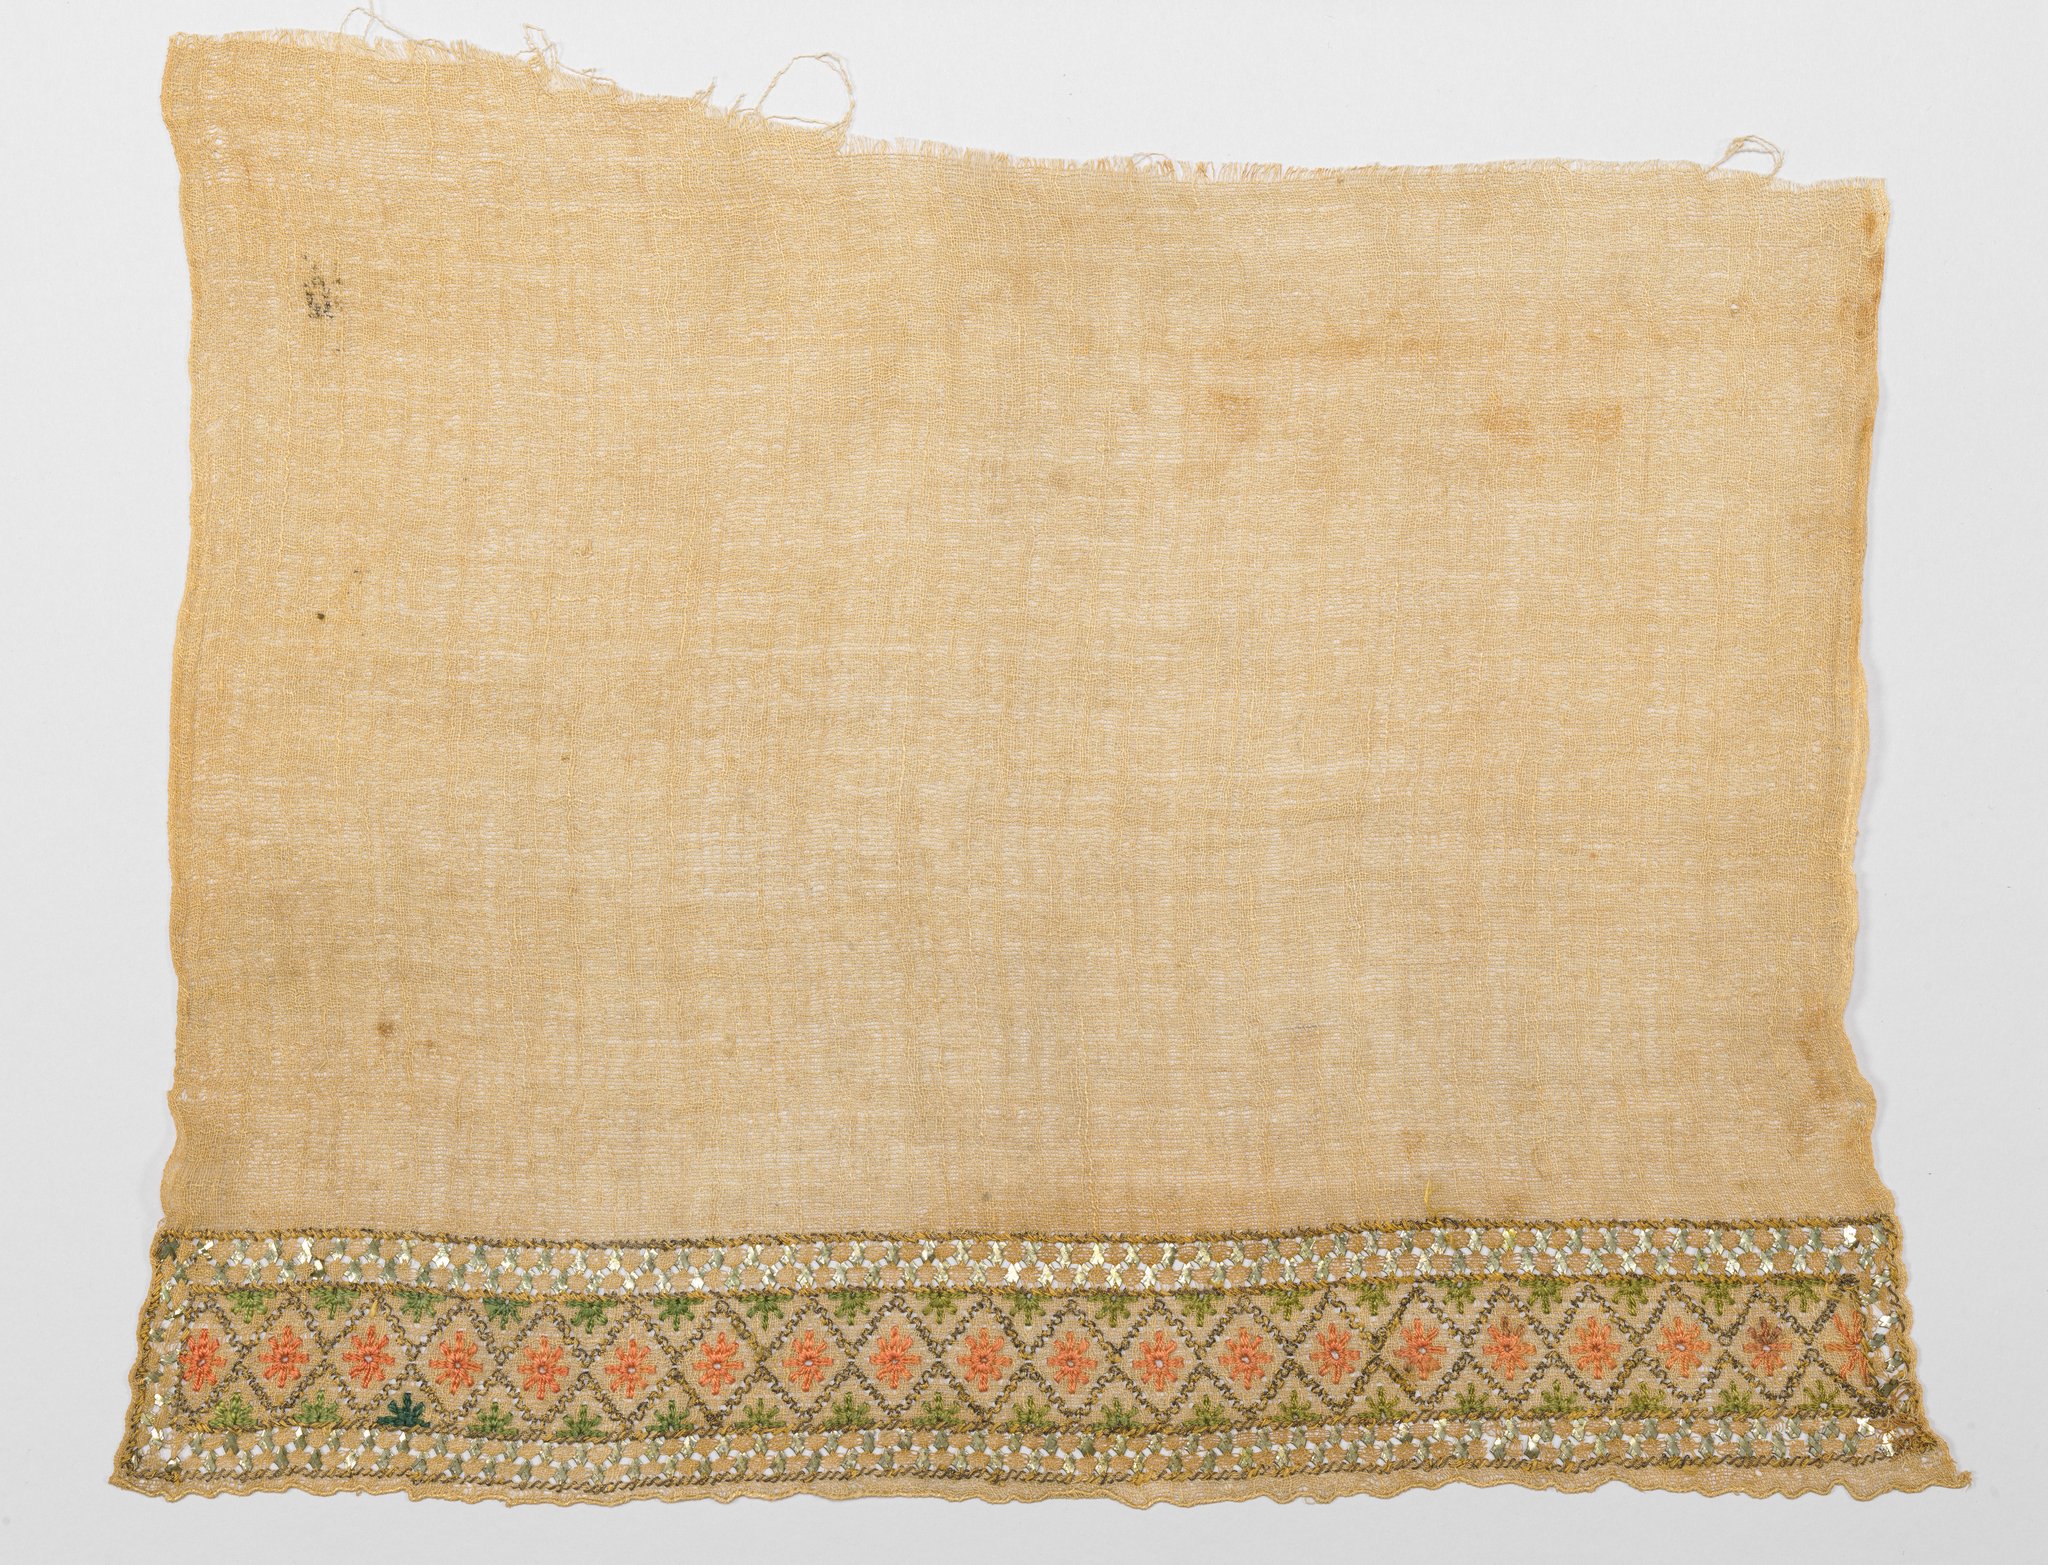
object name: towel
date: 1801-1900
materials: linen, silk, thread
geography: turkey